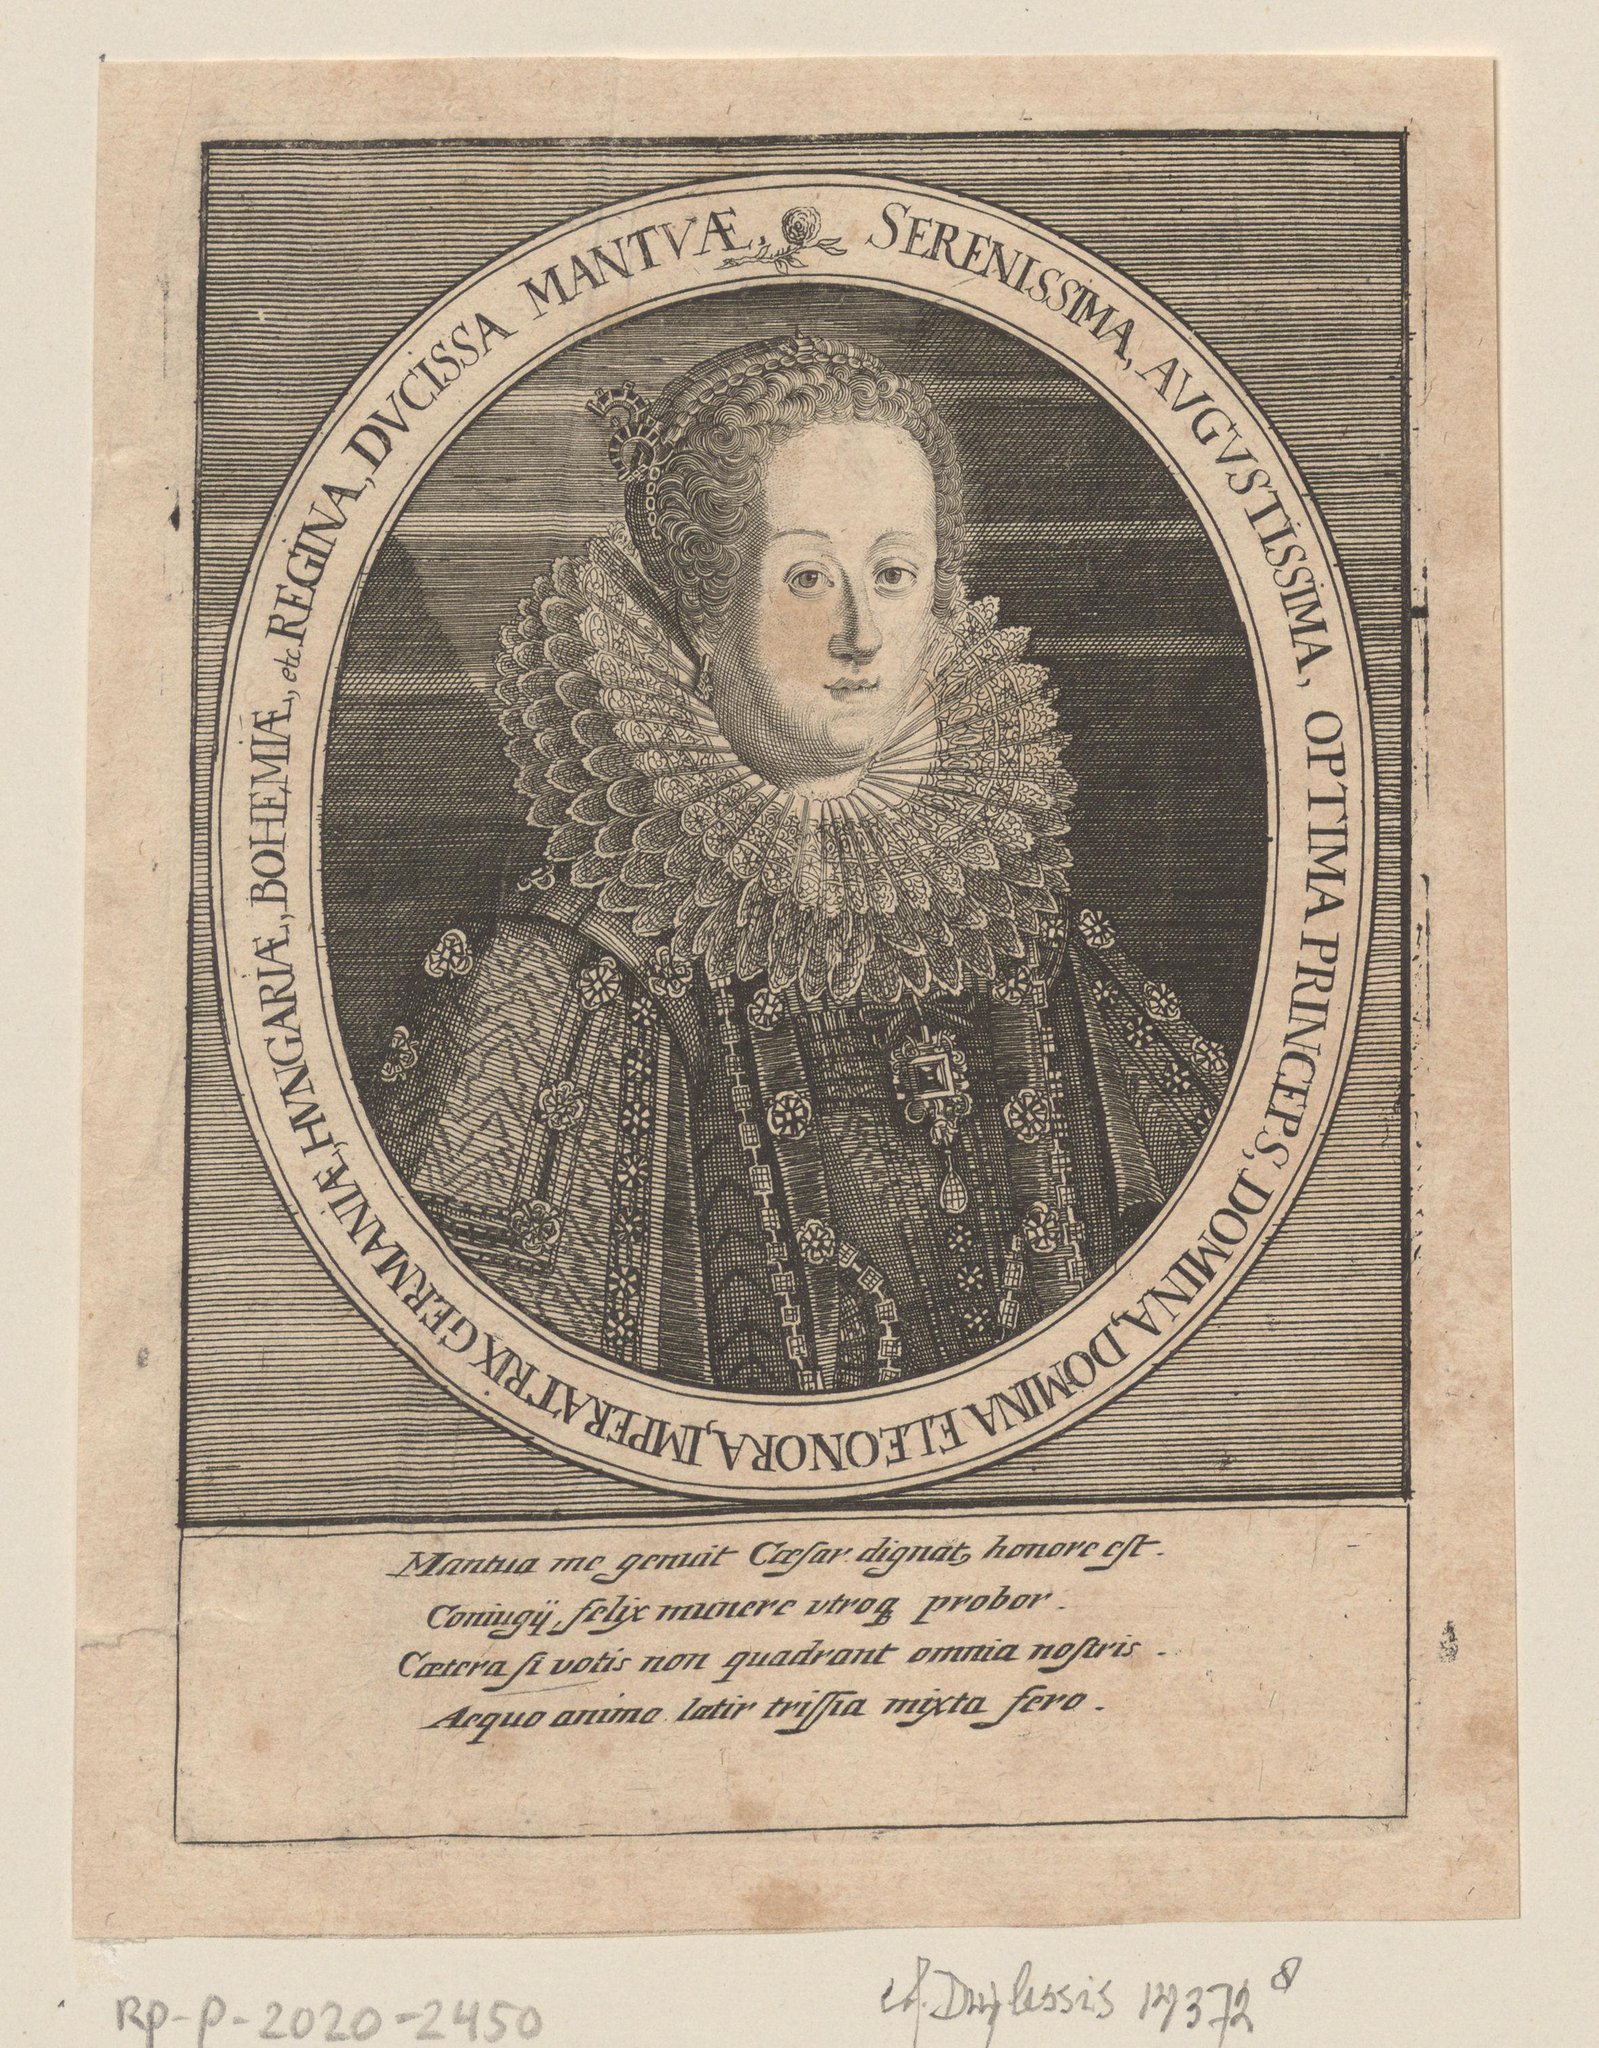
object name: print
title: Portret van Eleonora Gonzaga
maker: Anonymous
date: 1624-1650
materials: paper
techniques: engraving, etching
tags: vienna, historical persons - bb - woman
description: Met vierregelig onderschrift in het Latijn.